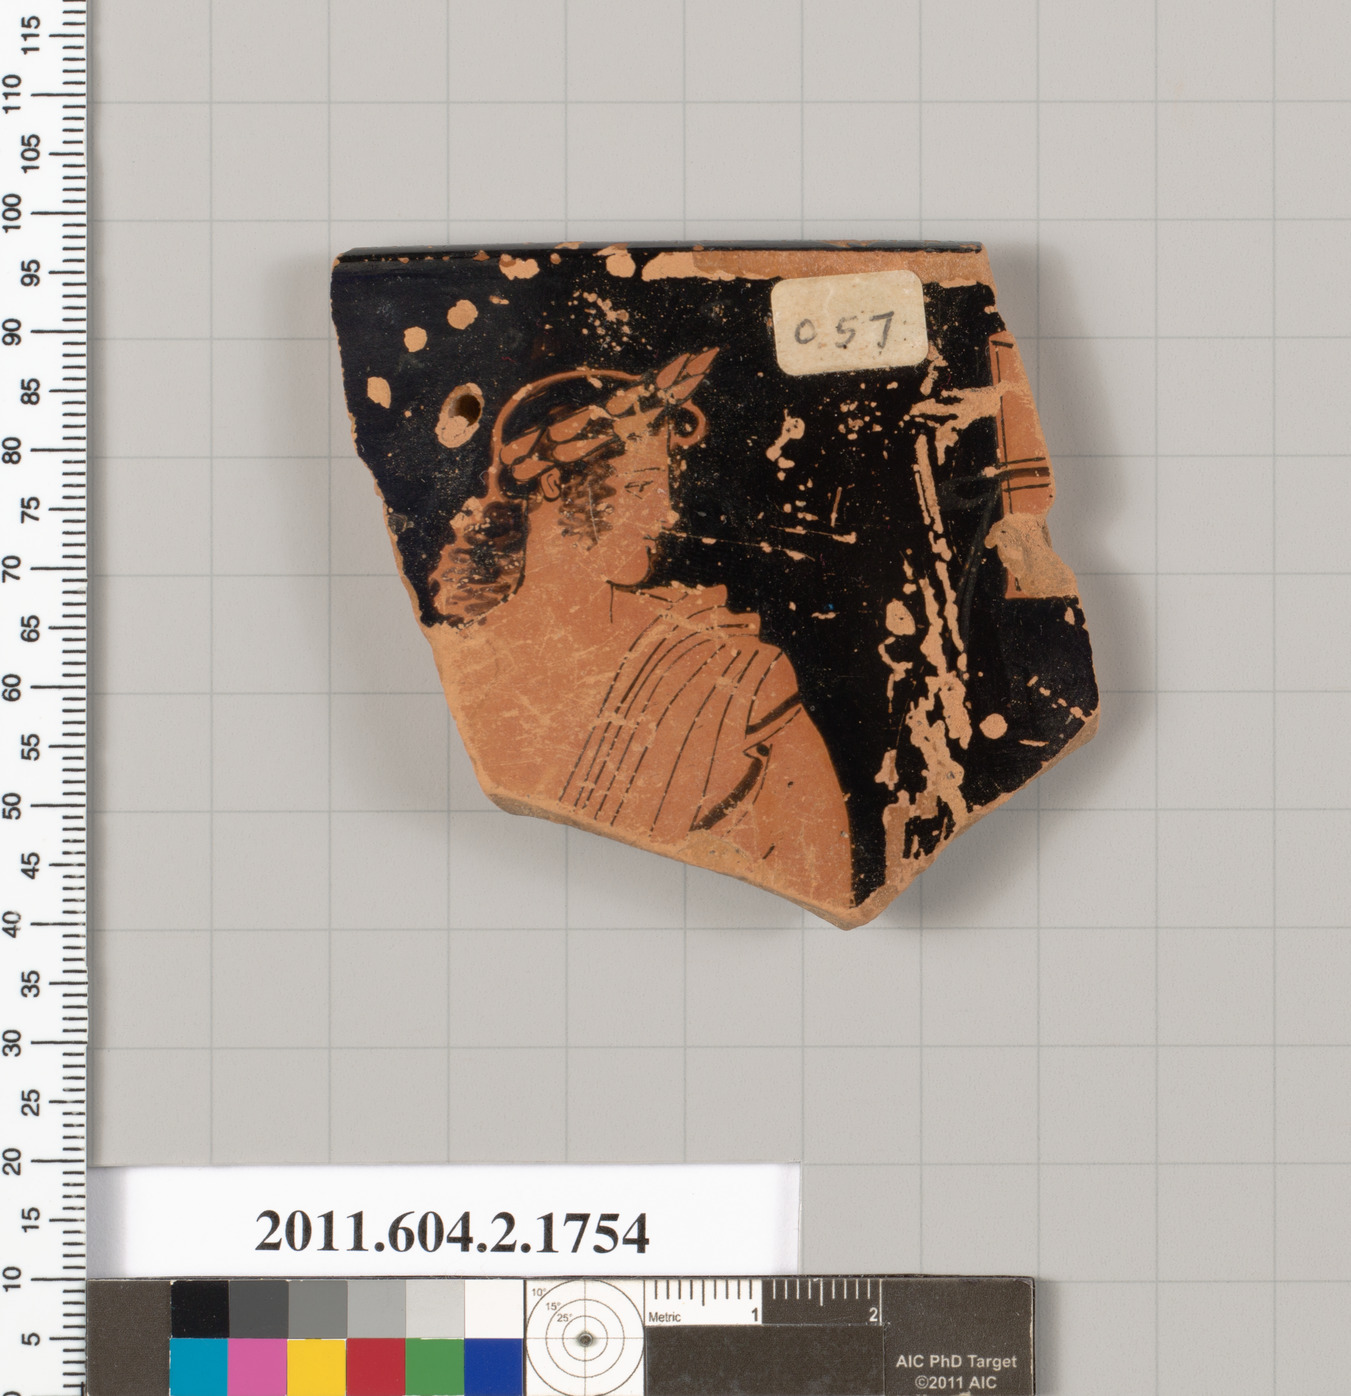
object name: skyphos fragment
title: Terracotta rim fragment of a skyphos (deep drinking cup)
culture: greek, attic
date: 460-450 BCE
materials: terracotta